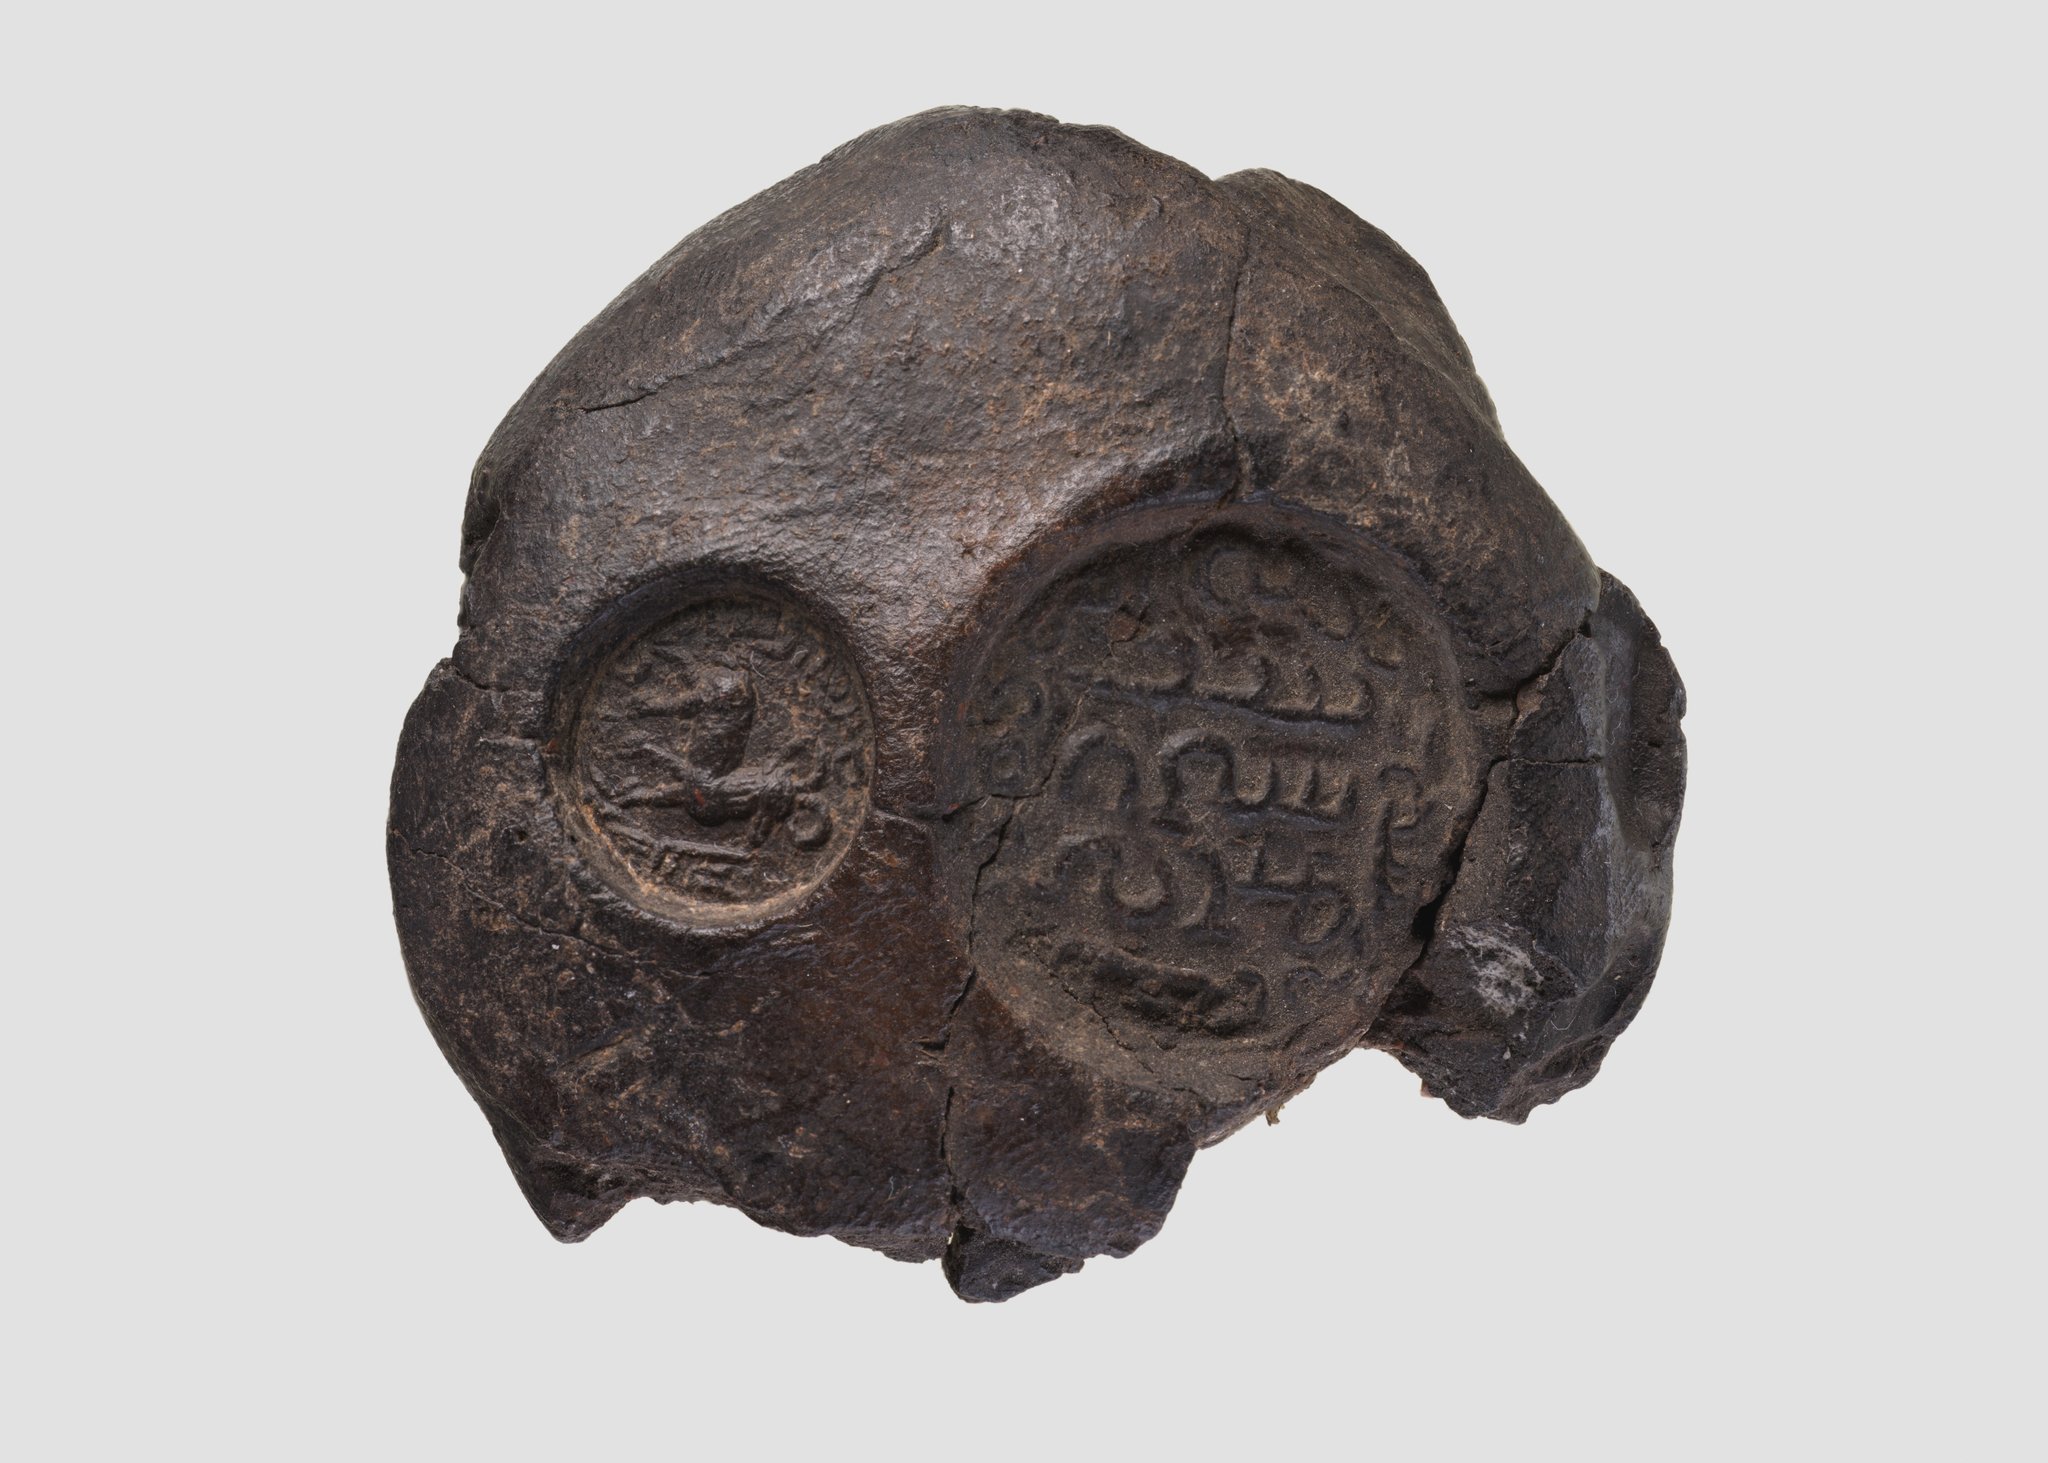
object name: sealing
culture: sasanian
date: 601-700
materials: clay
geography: iran